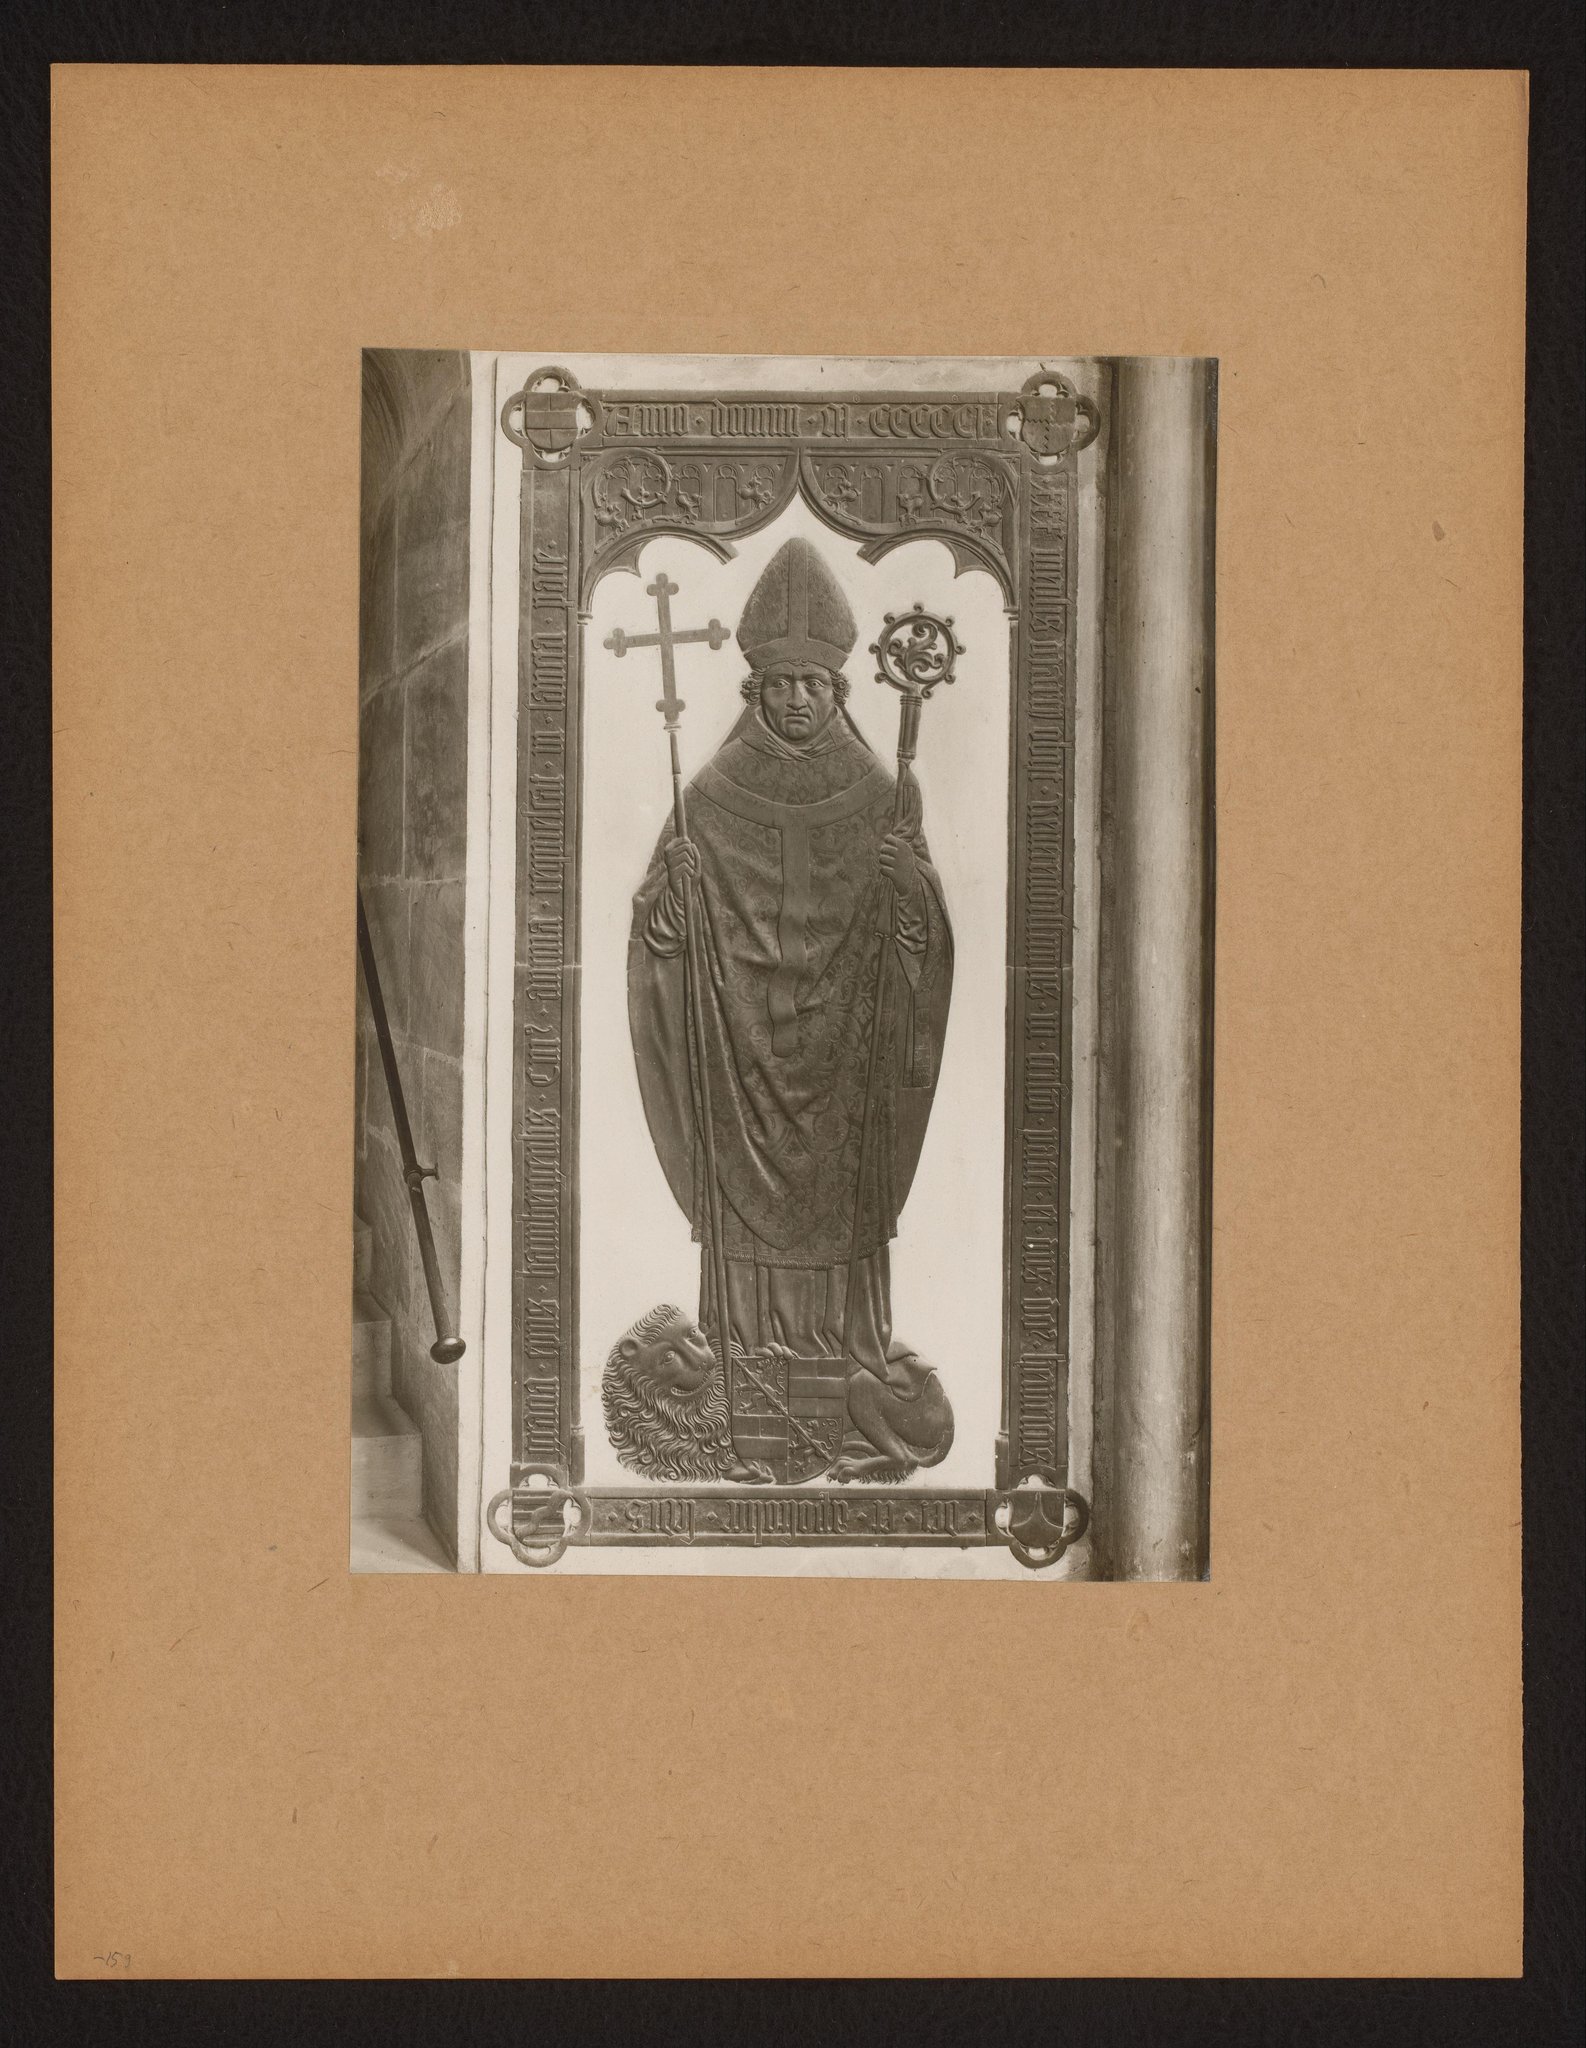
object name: photograph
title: Graf van Heinrich III Groß von Trockau in de dom van Bamberg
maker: Anonymous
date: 1900-1920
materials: paper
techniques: gelatin silver print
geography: bamberg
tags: interior of church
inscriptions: number: ‘162’